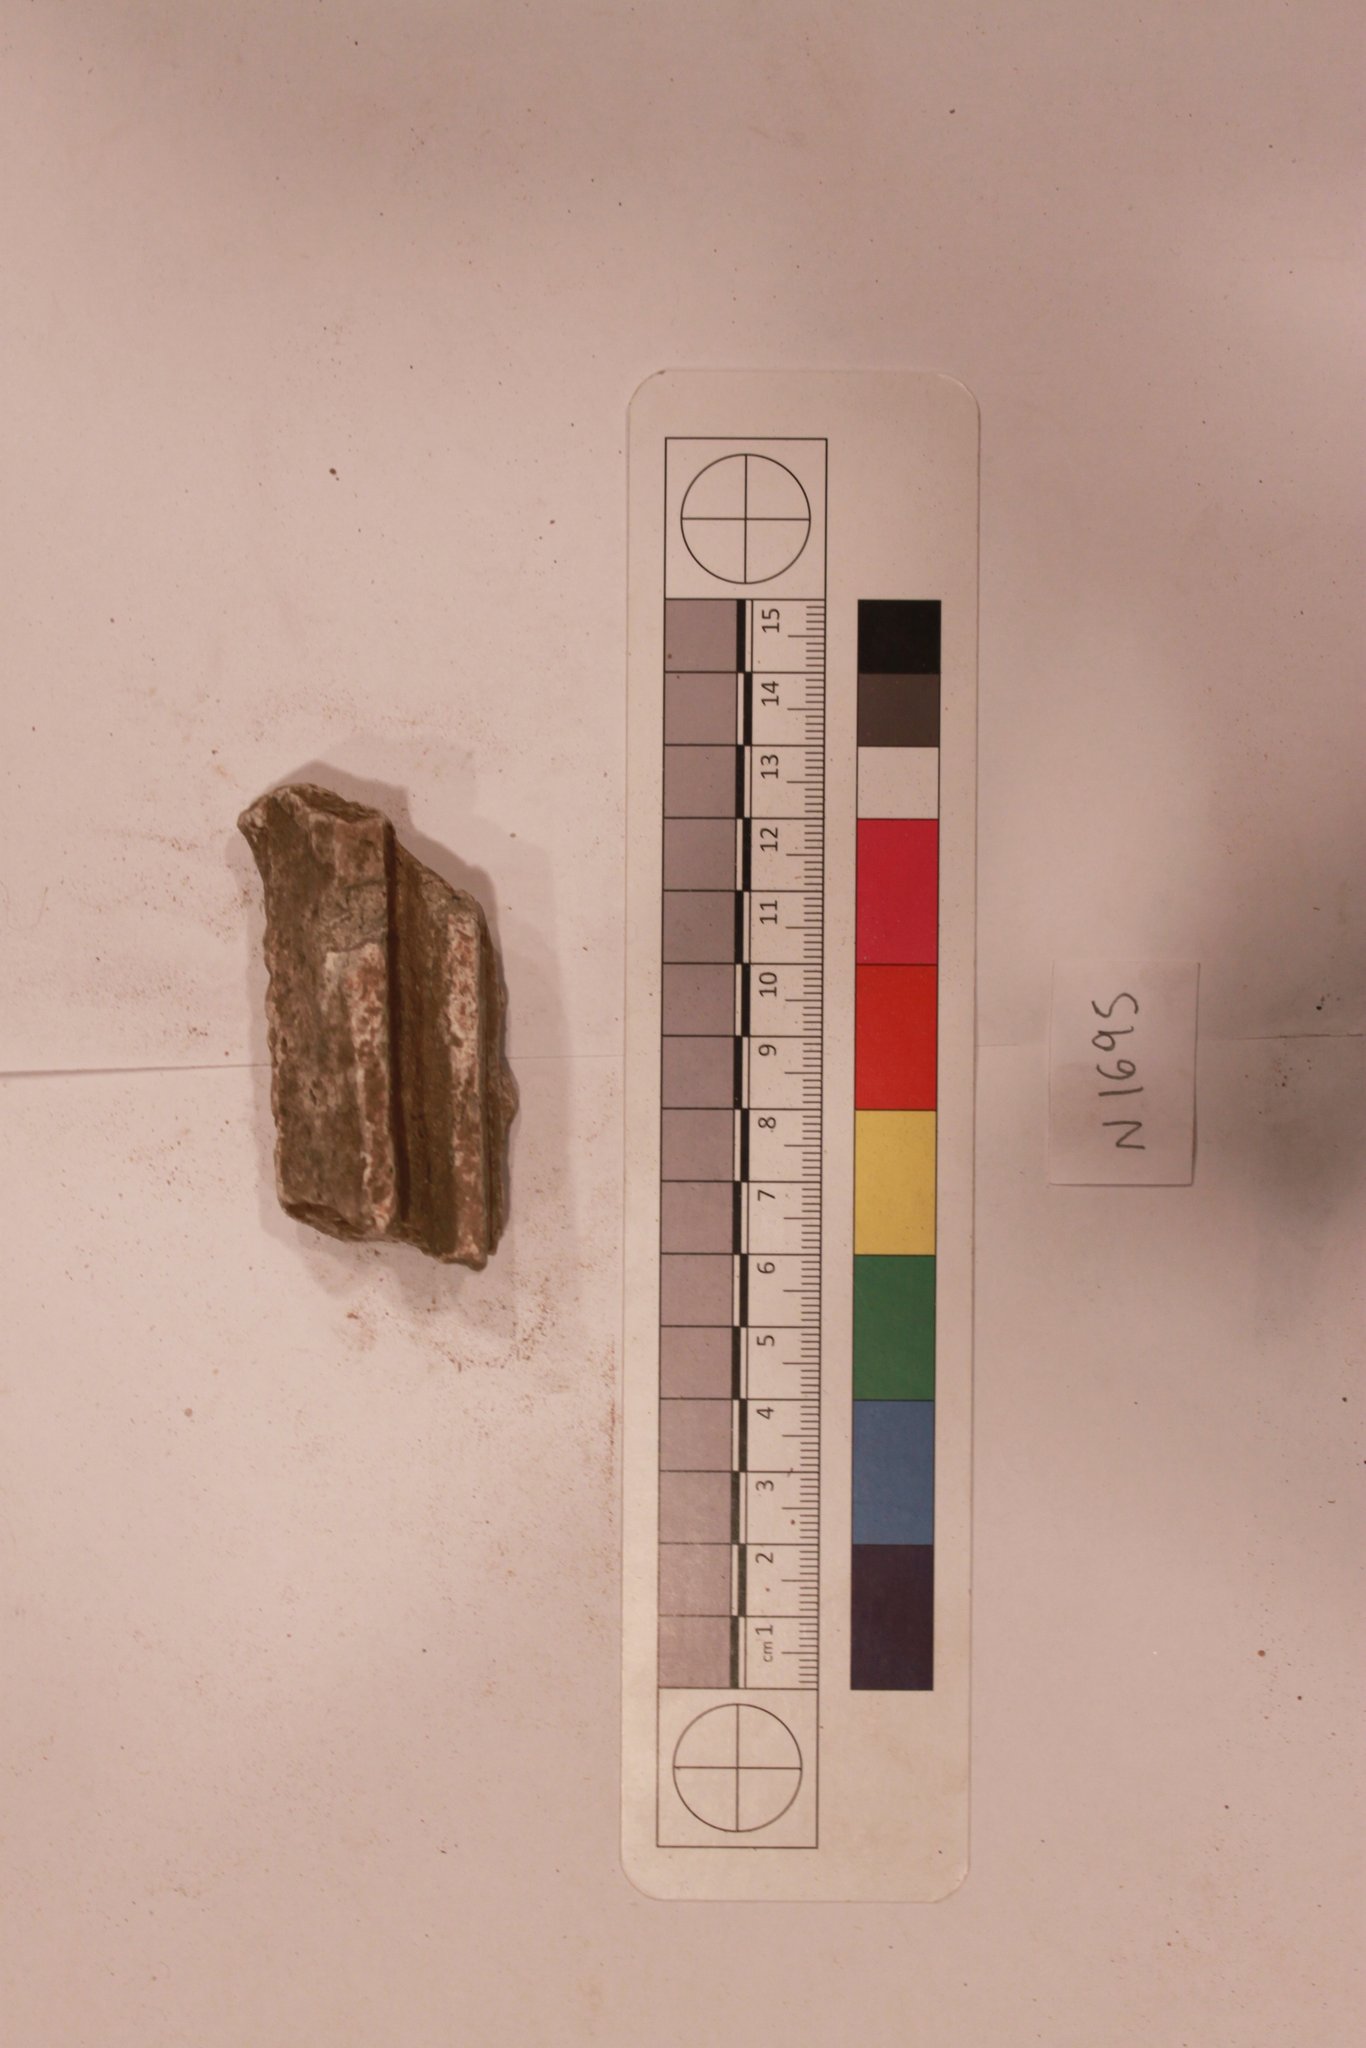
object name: fragment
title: Stucco Fragment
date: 701-1200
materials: plaster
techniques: carving, painting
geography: iran